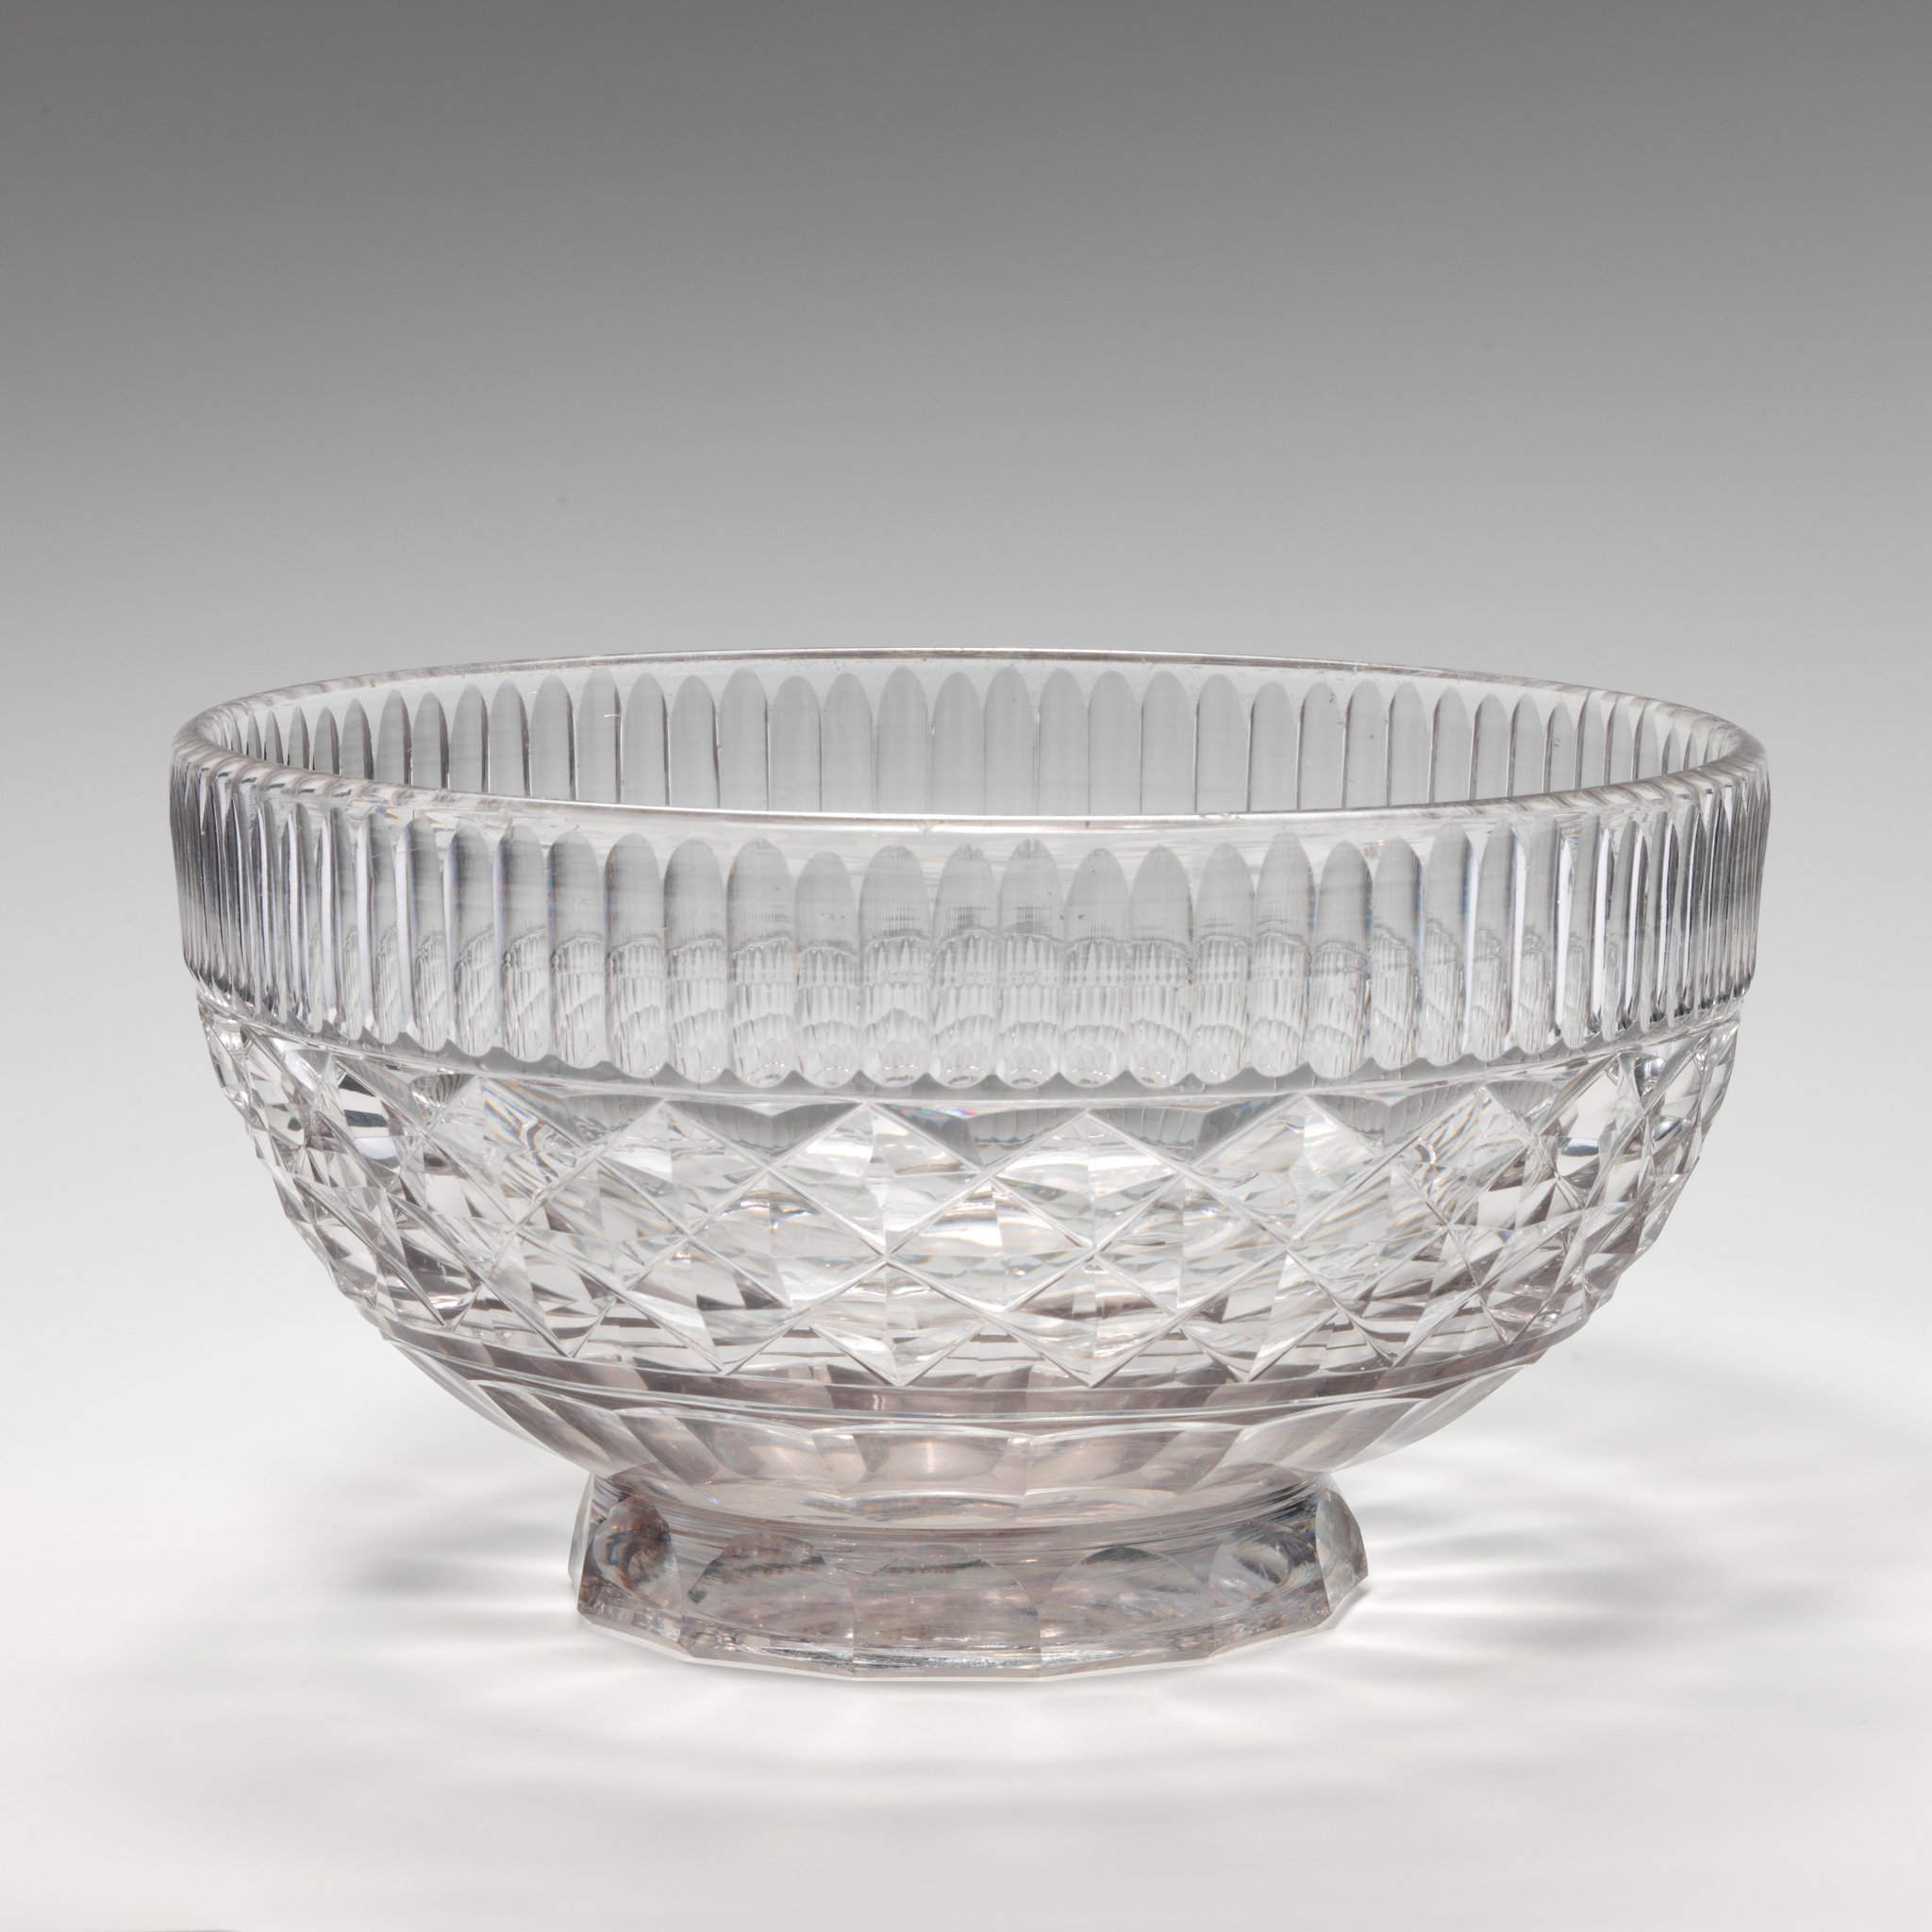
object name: bowl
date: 1767-1833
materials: glass